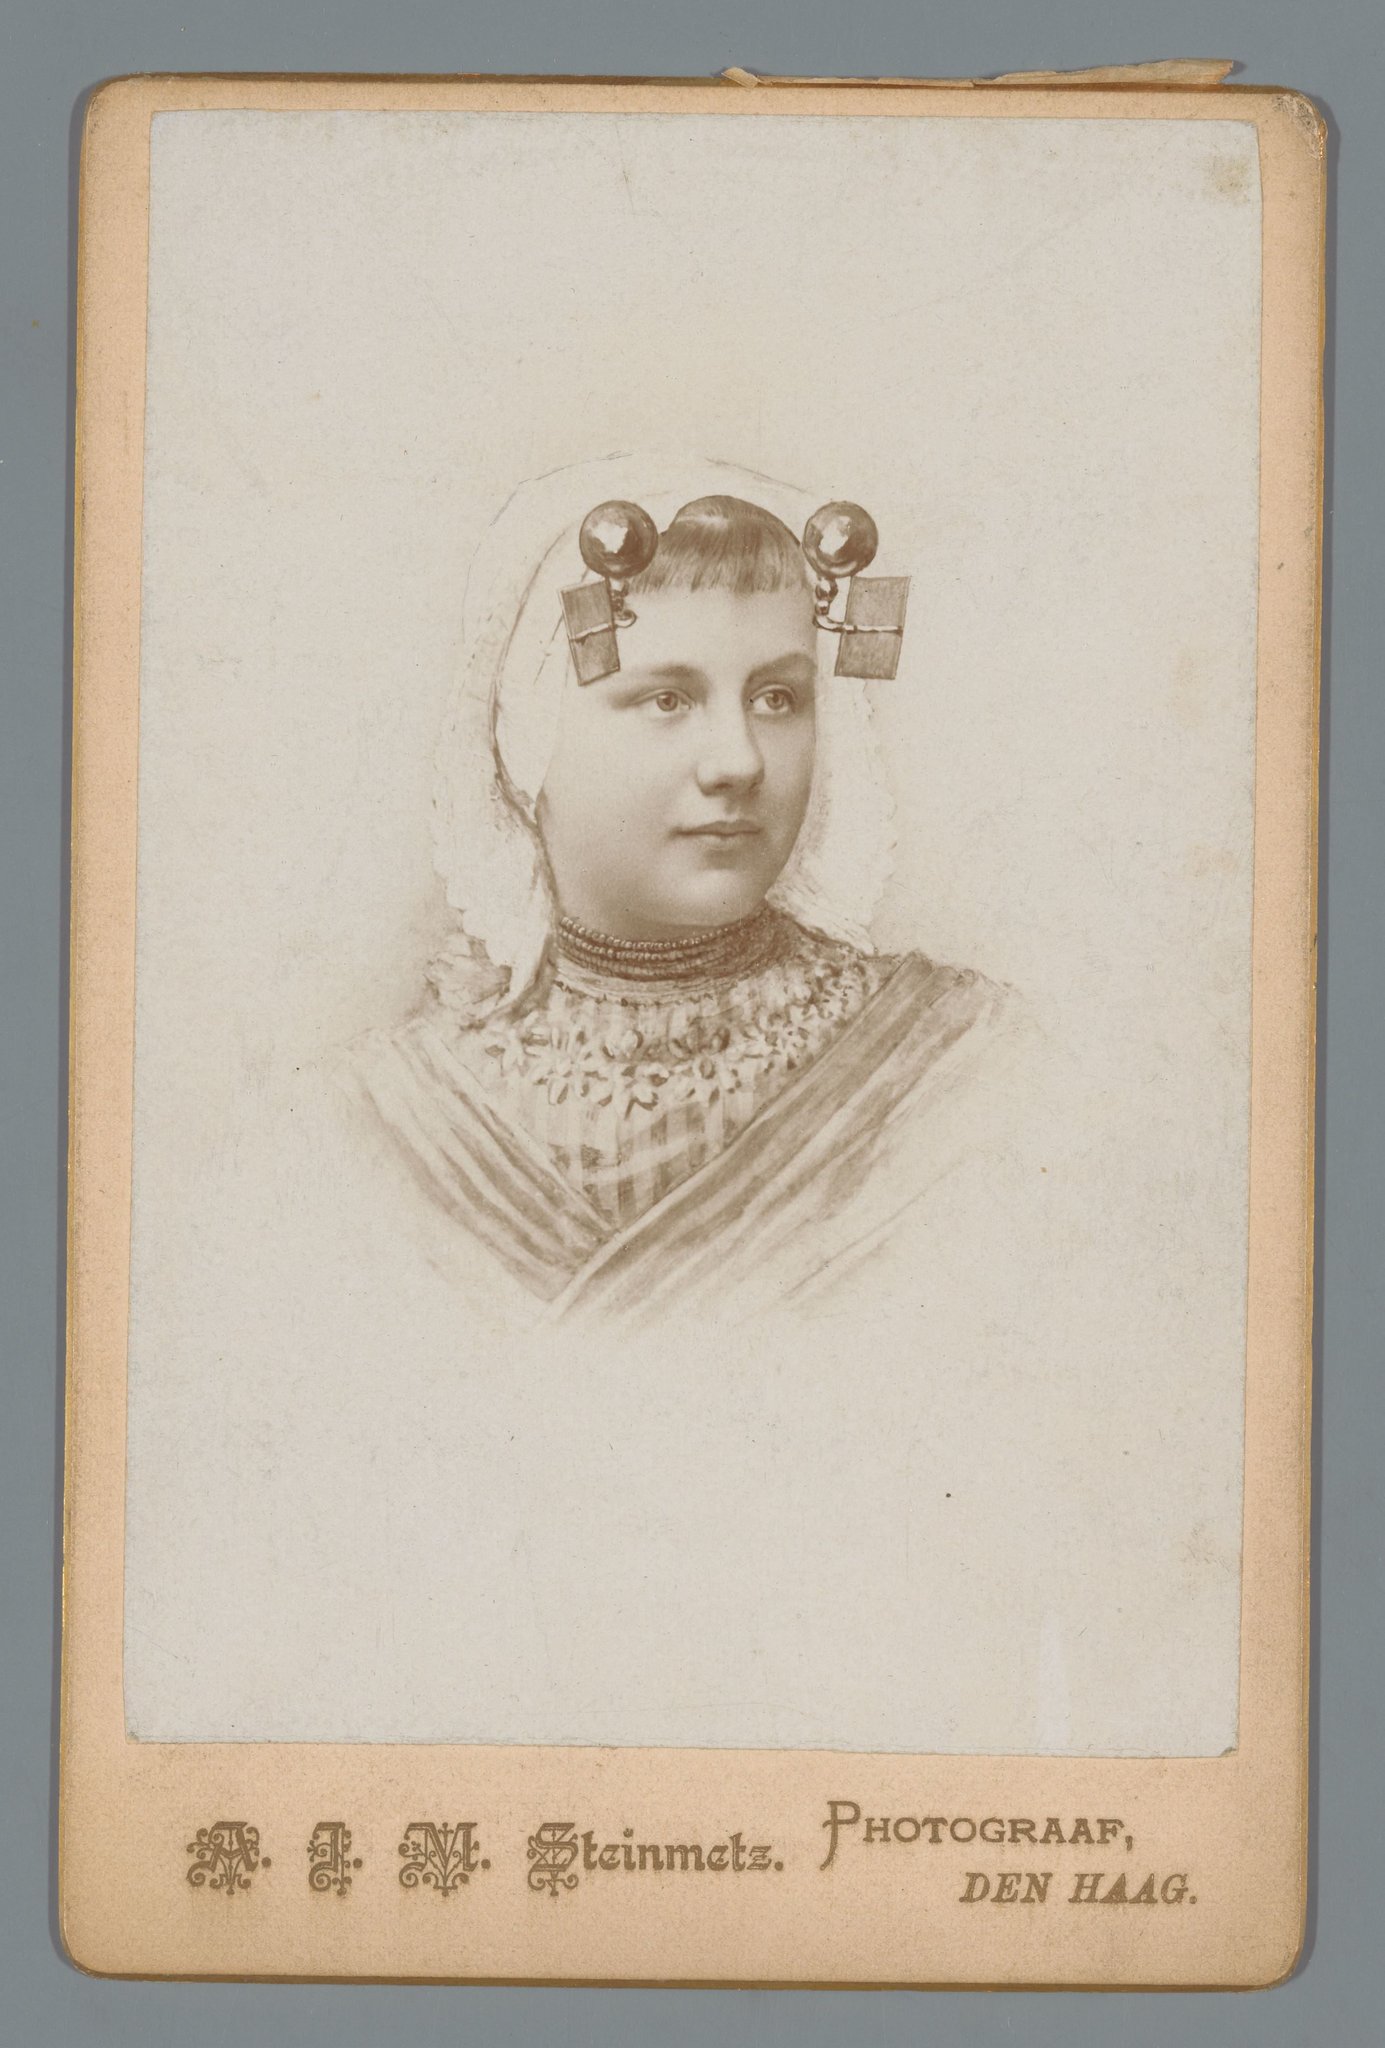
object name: cabinet photograph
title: Portret van koningin Wilhelmina, met muts volgens de klederdracht van Zuid-Beveland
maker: antoine johan marinus steinmetz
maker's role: fotograaf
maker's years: 1867-1950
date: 1894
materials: cardboard, photographic support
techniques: collodion silver print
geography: the hague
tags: the hague, print maker, wilhelmina of the netherlands, historical persons, queen, head-gear: cap, folk costume, regional costume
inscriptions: number: ‘40’, inscription: ‘Wilhelmina/ Walcheren/ 4-25/8 - 1894’